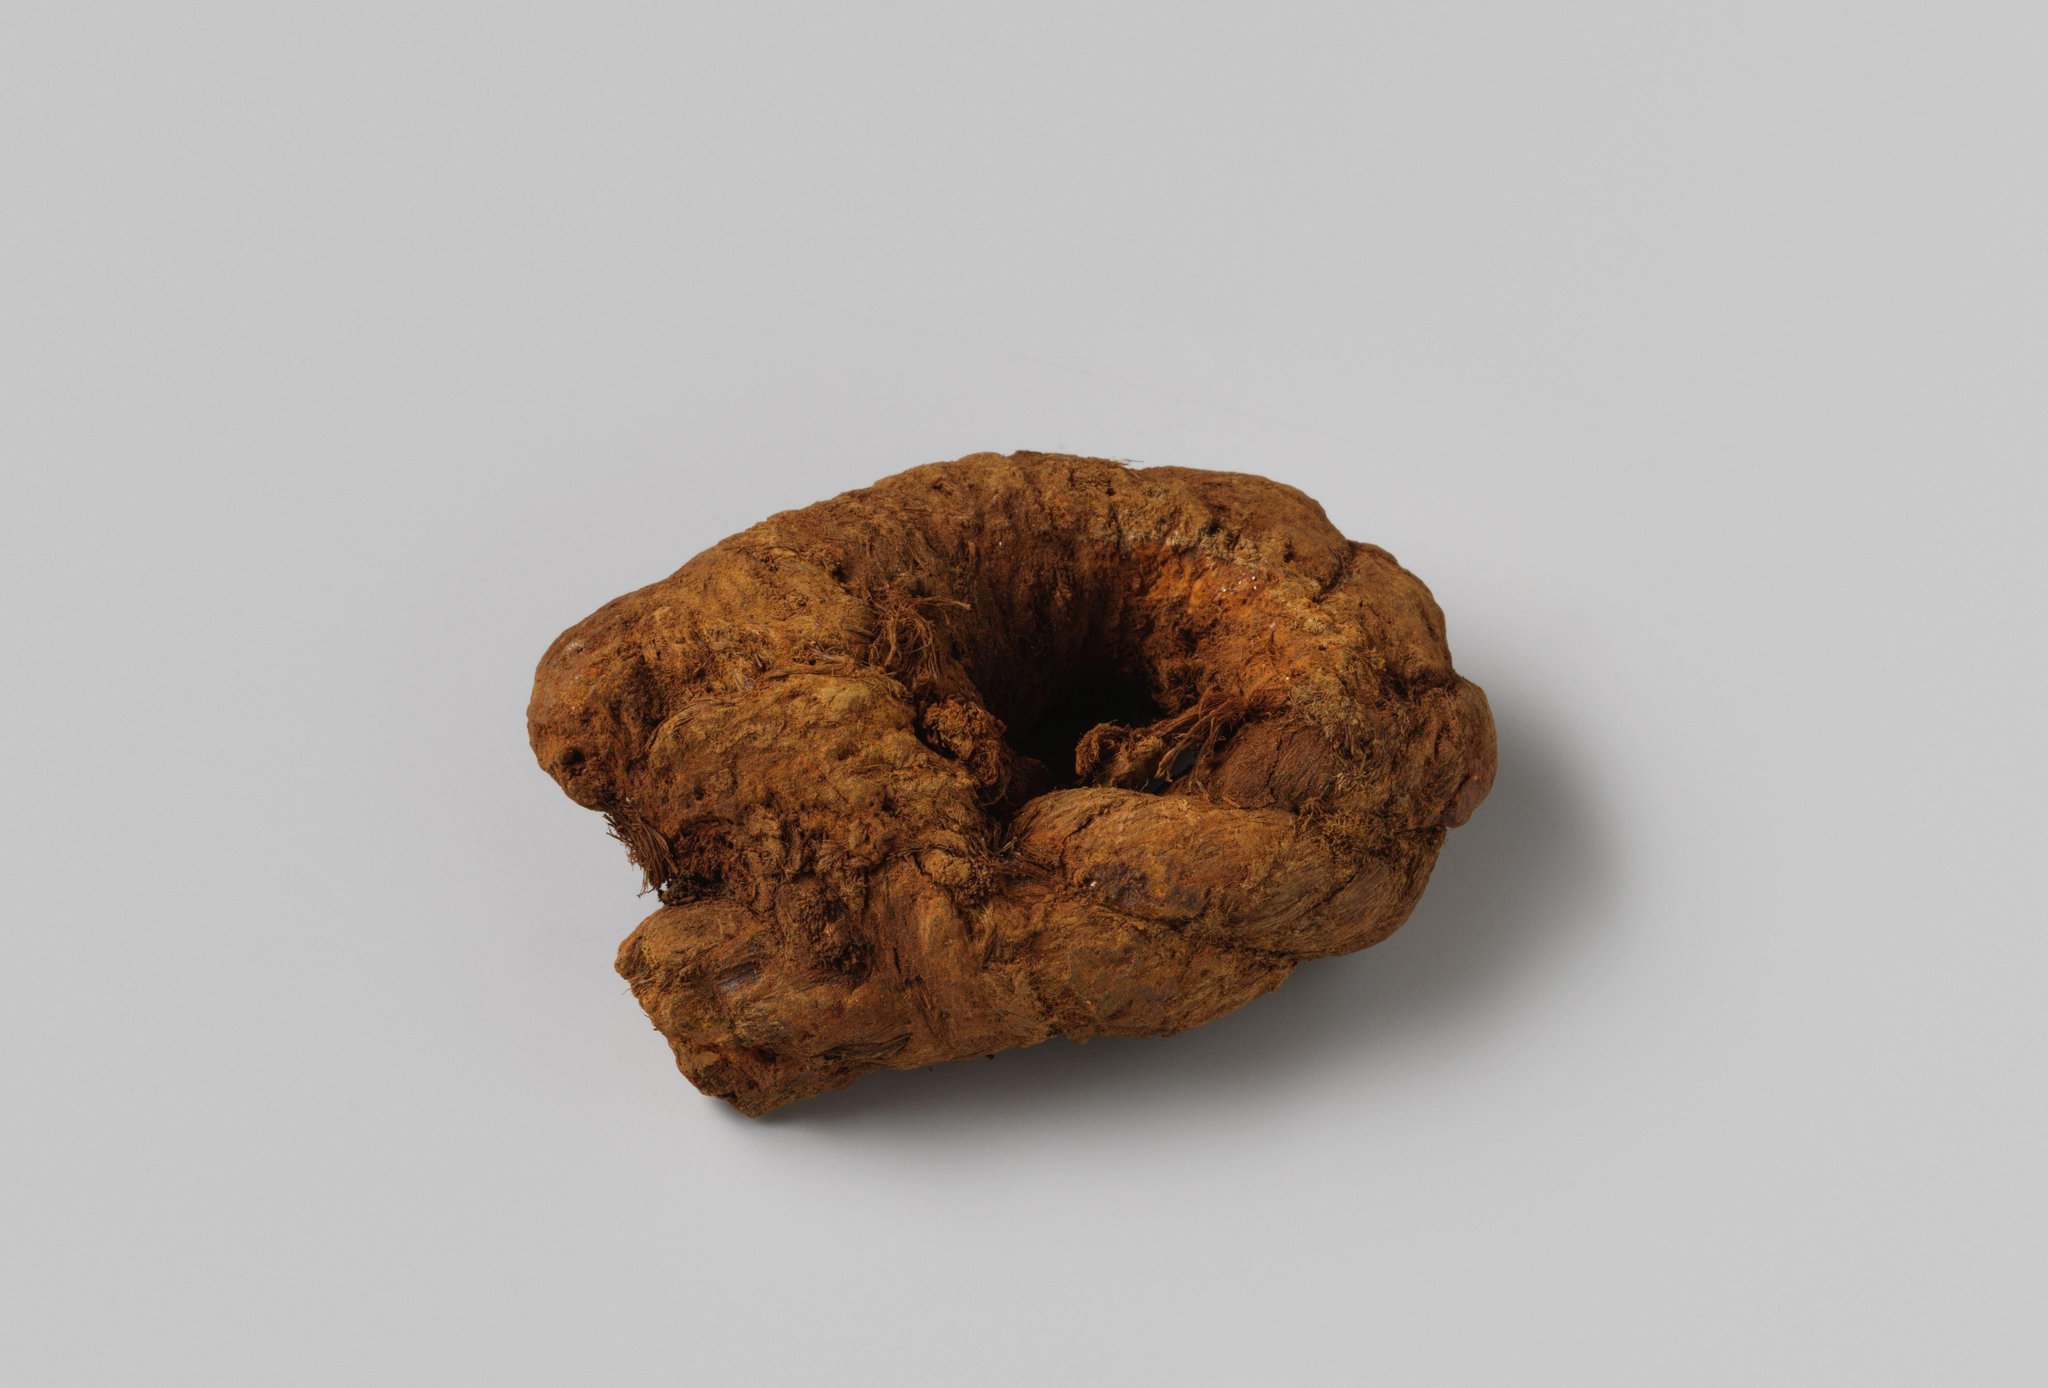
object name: rope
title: Opgerold touw uit het wrak van de Oost-Indiëvaarder Hollandia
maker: Anonymous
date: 1700-1743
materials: fiber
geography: netherlands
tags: verenigde oostindische compagnie, hollandia (schip), annet